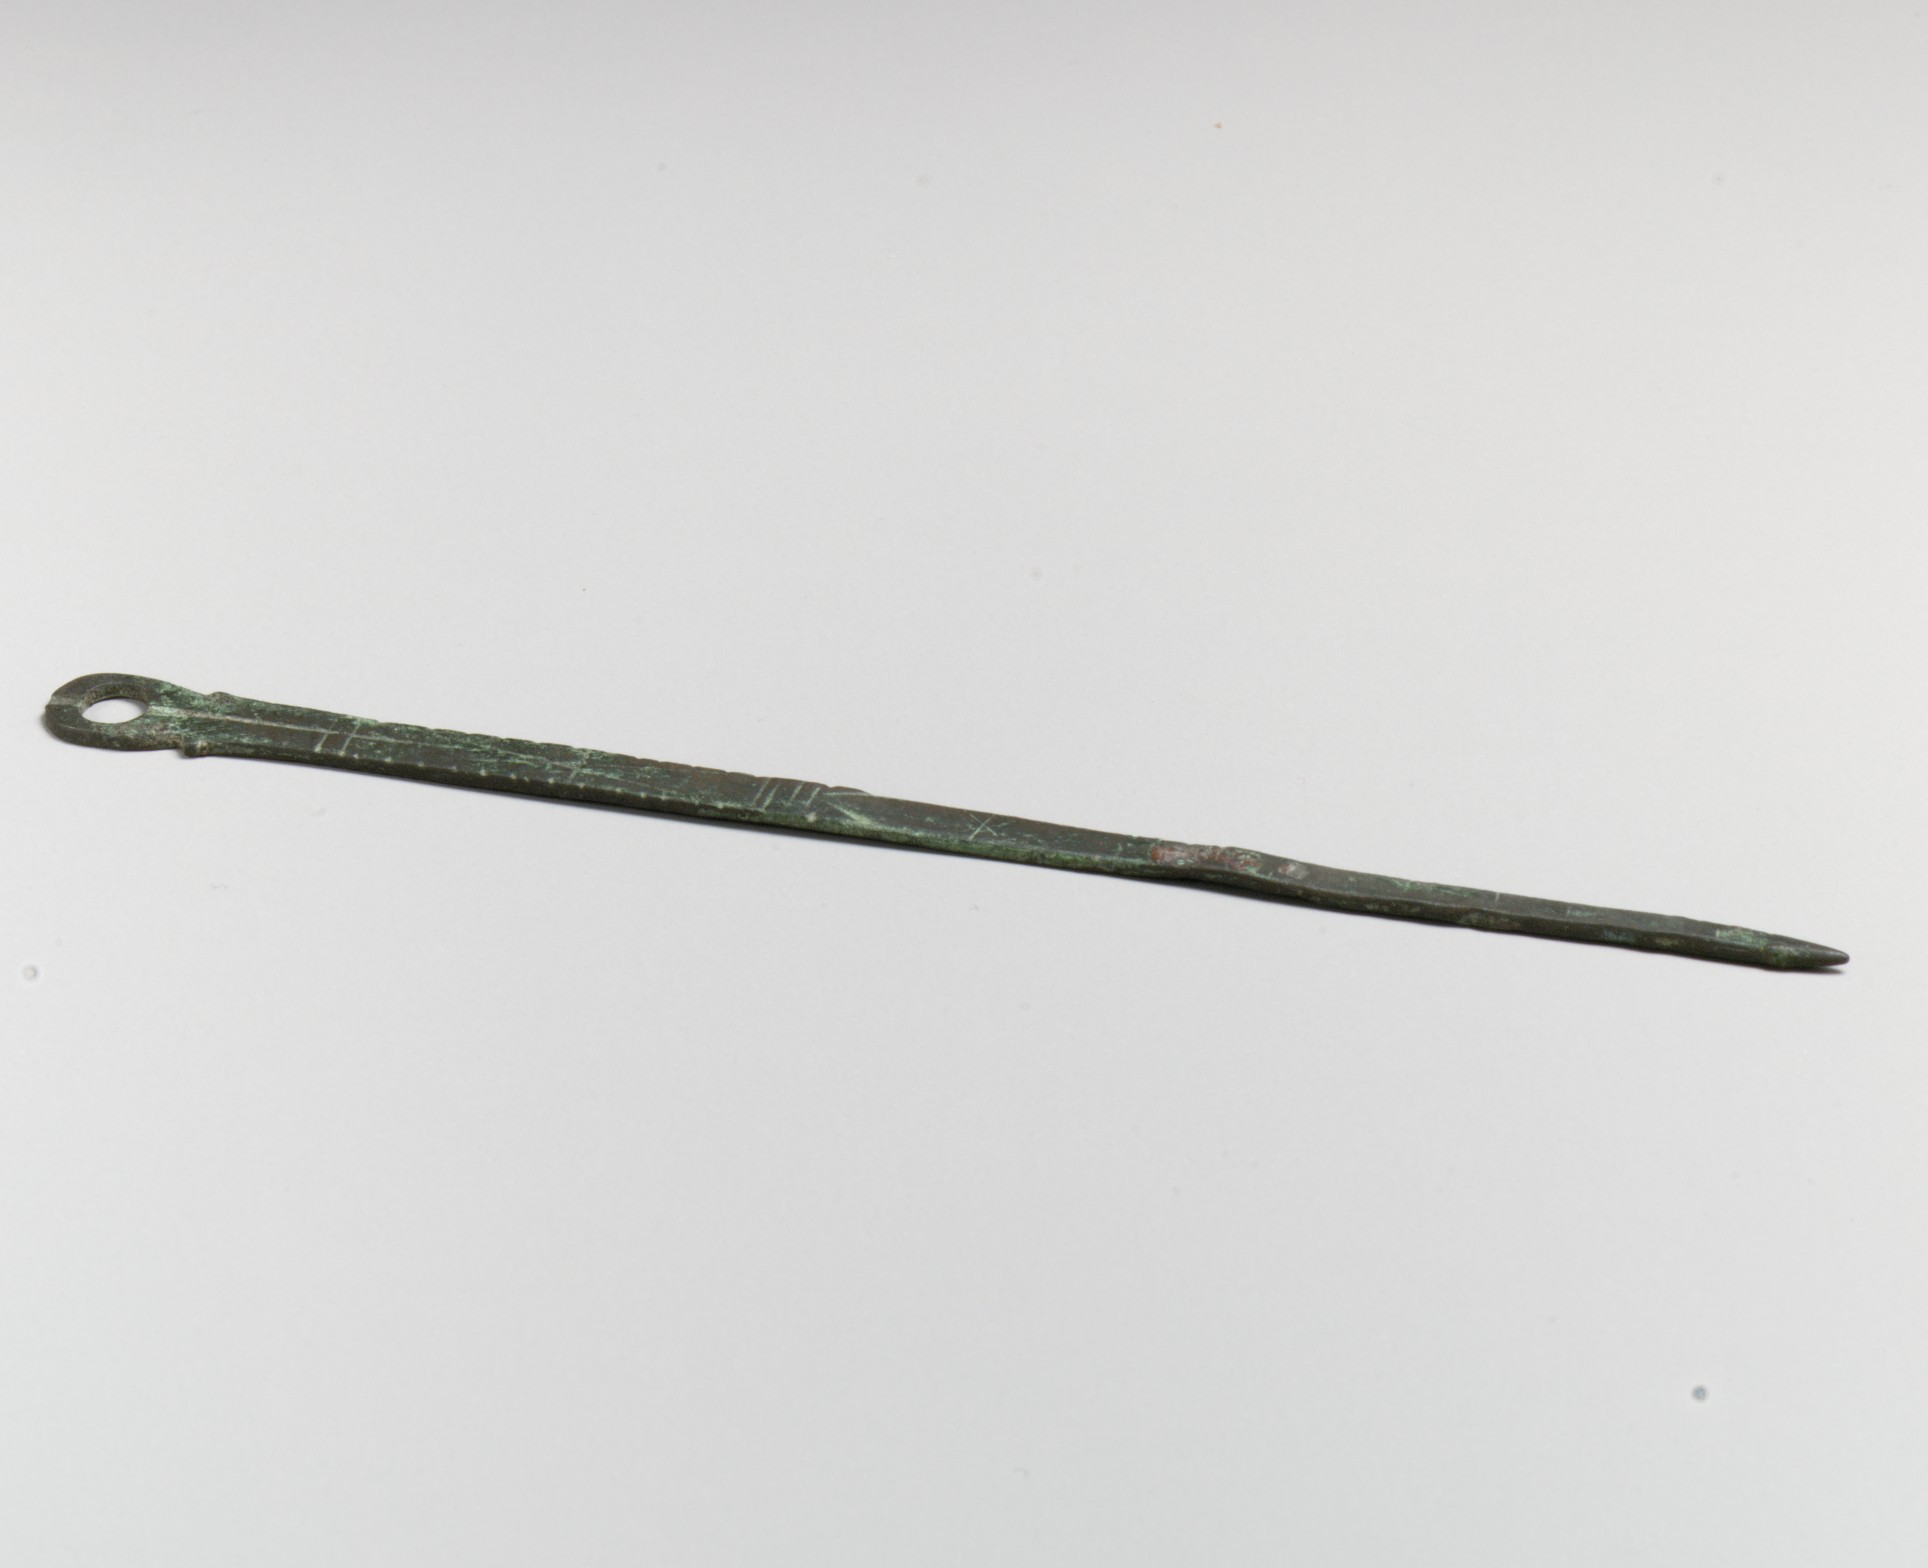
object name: compass or divider, fragment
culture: roman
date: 670 BCE-330 CE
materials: bronze